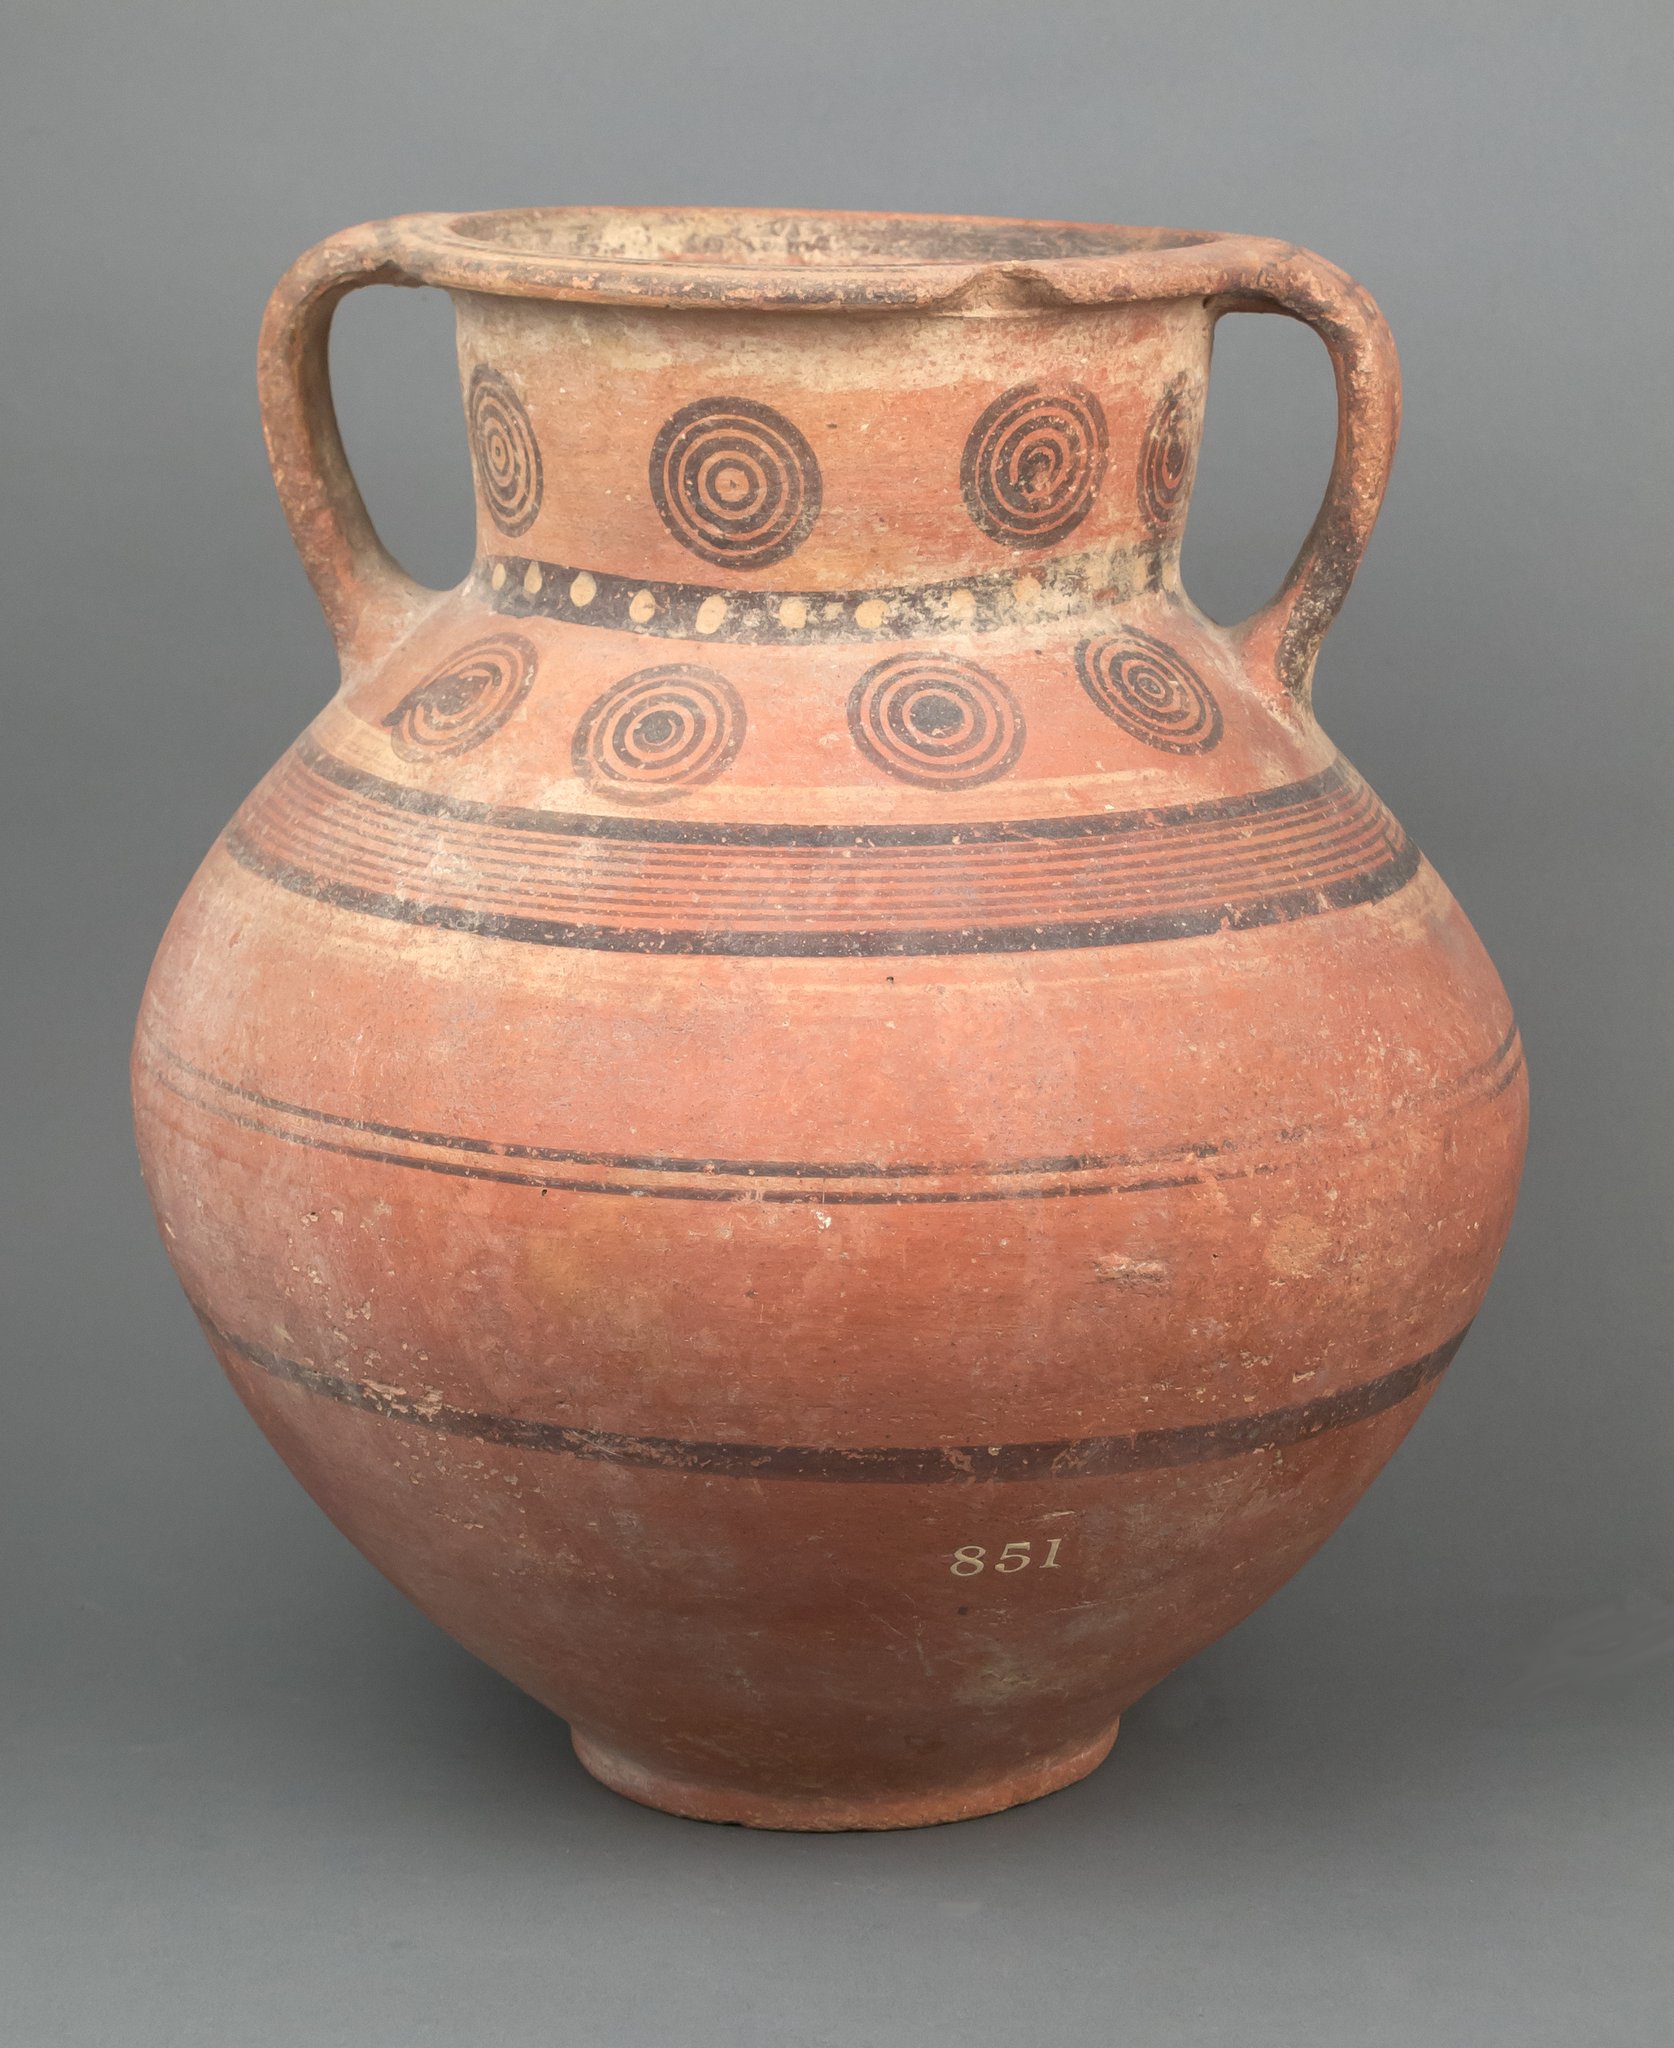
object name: amphora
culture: cypriot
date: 750-480 BCE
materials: terracotta